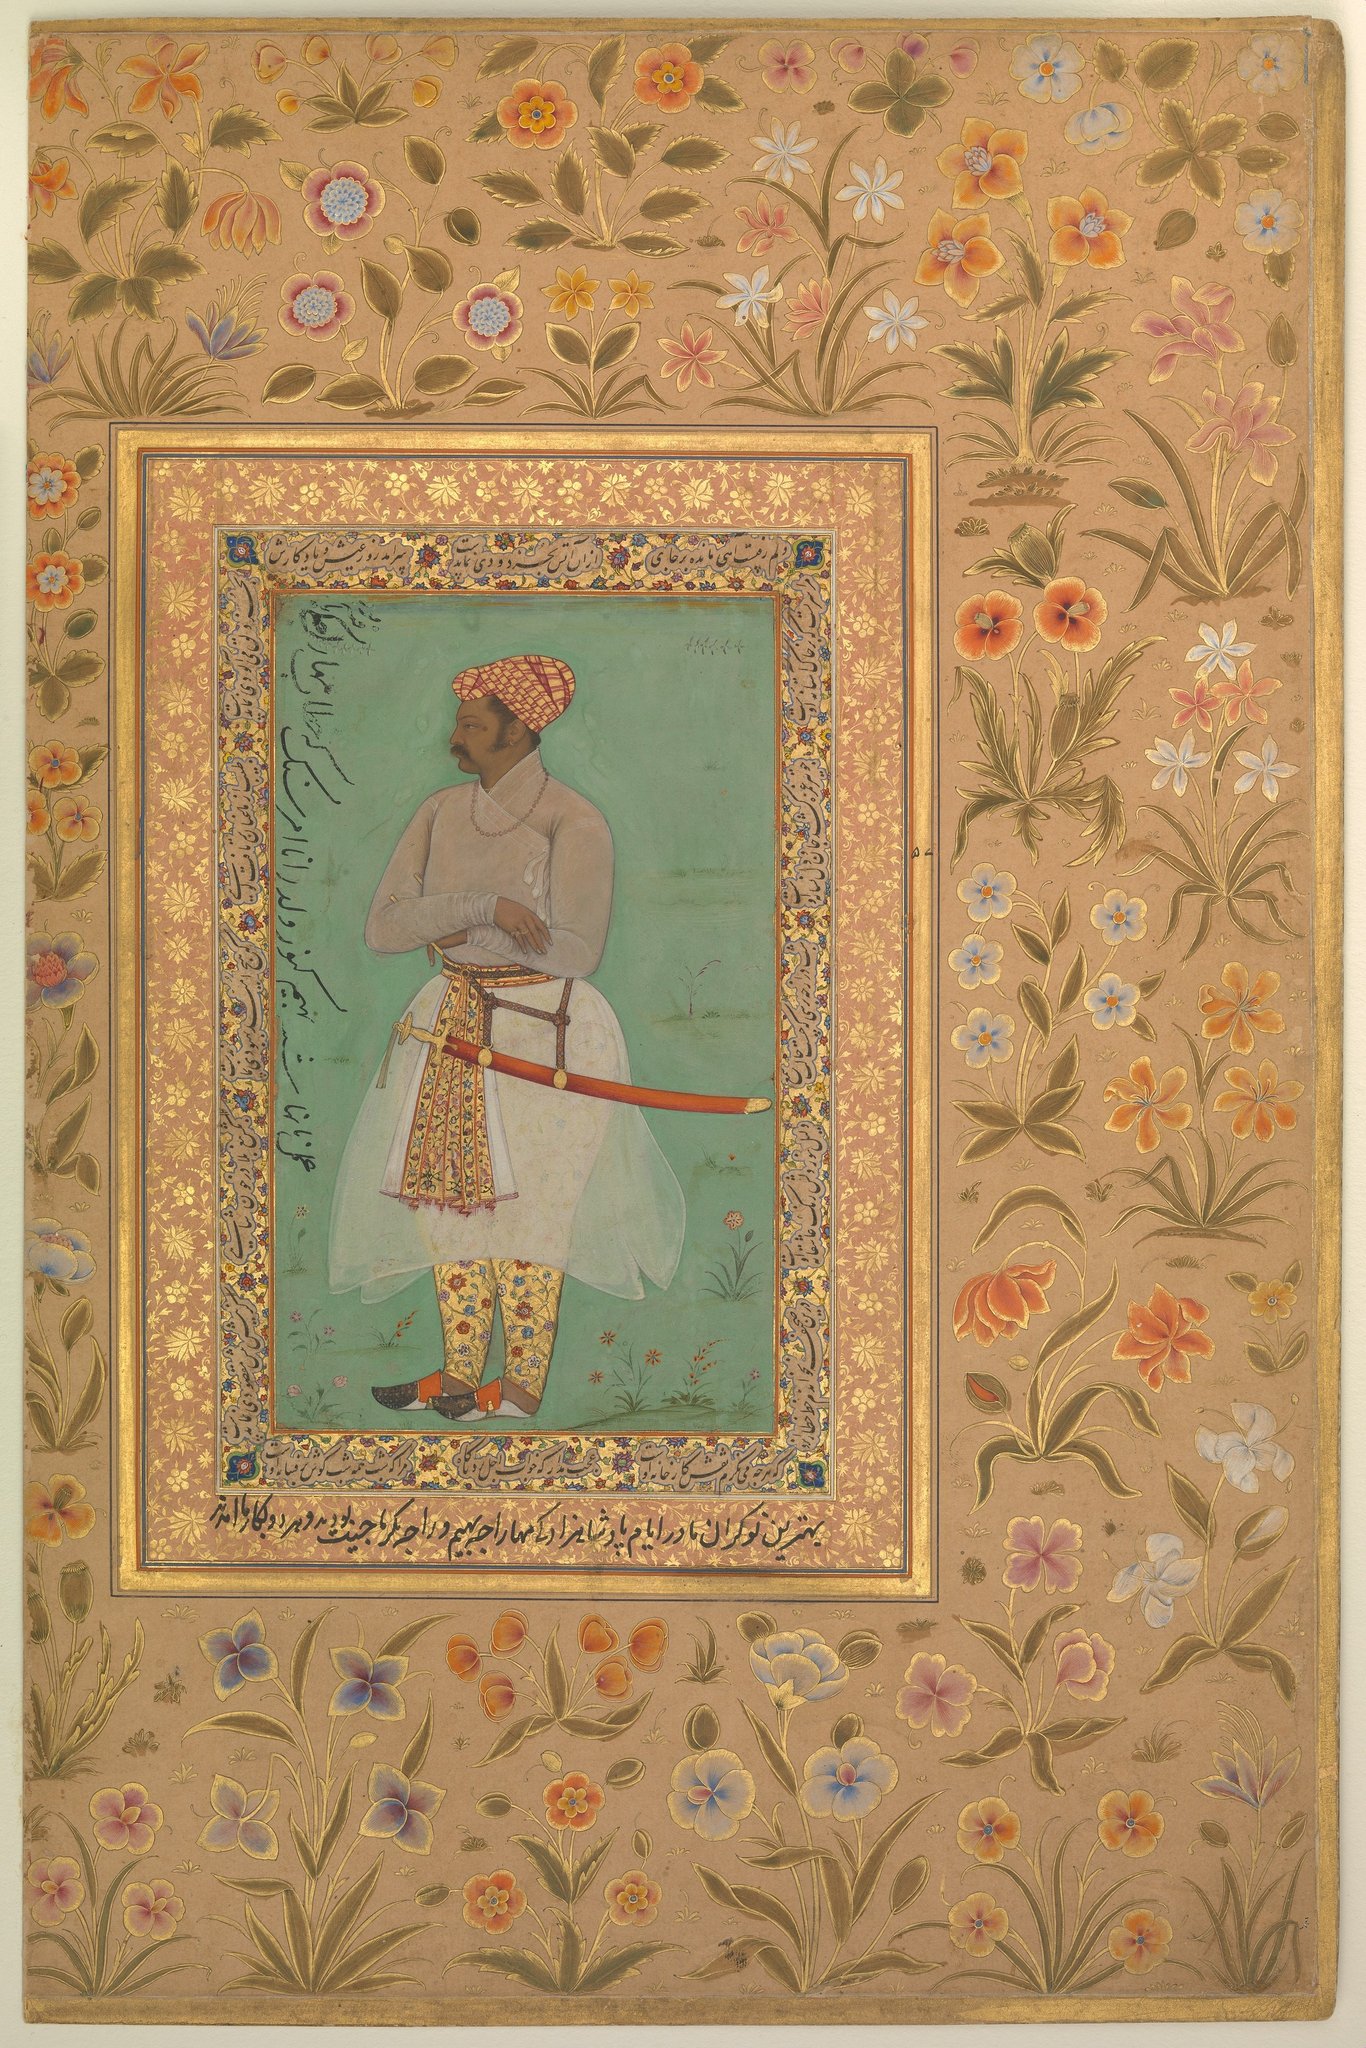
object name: album leaf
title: "Portrait of Maharaja Bhim Kanwar", Folio from the Shah Jahan Album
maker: nanha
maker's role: artist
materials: gold, ink, paper, watercolor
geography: india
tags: swords,men,portraits,flowers